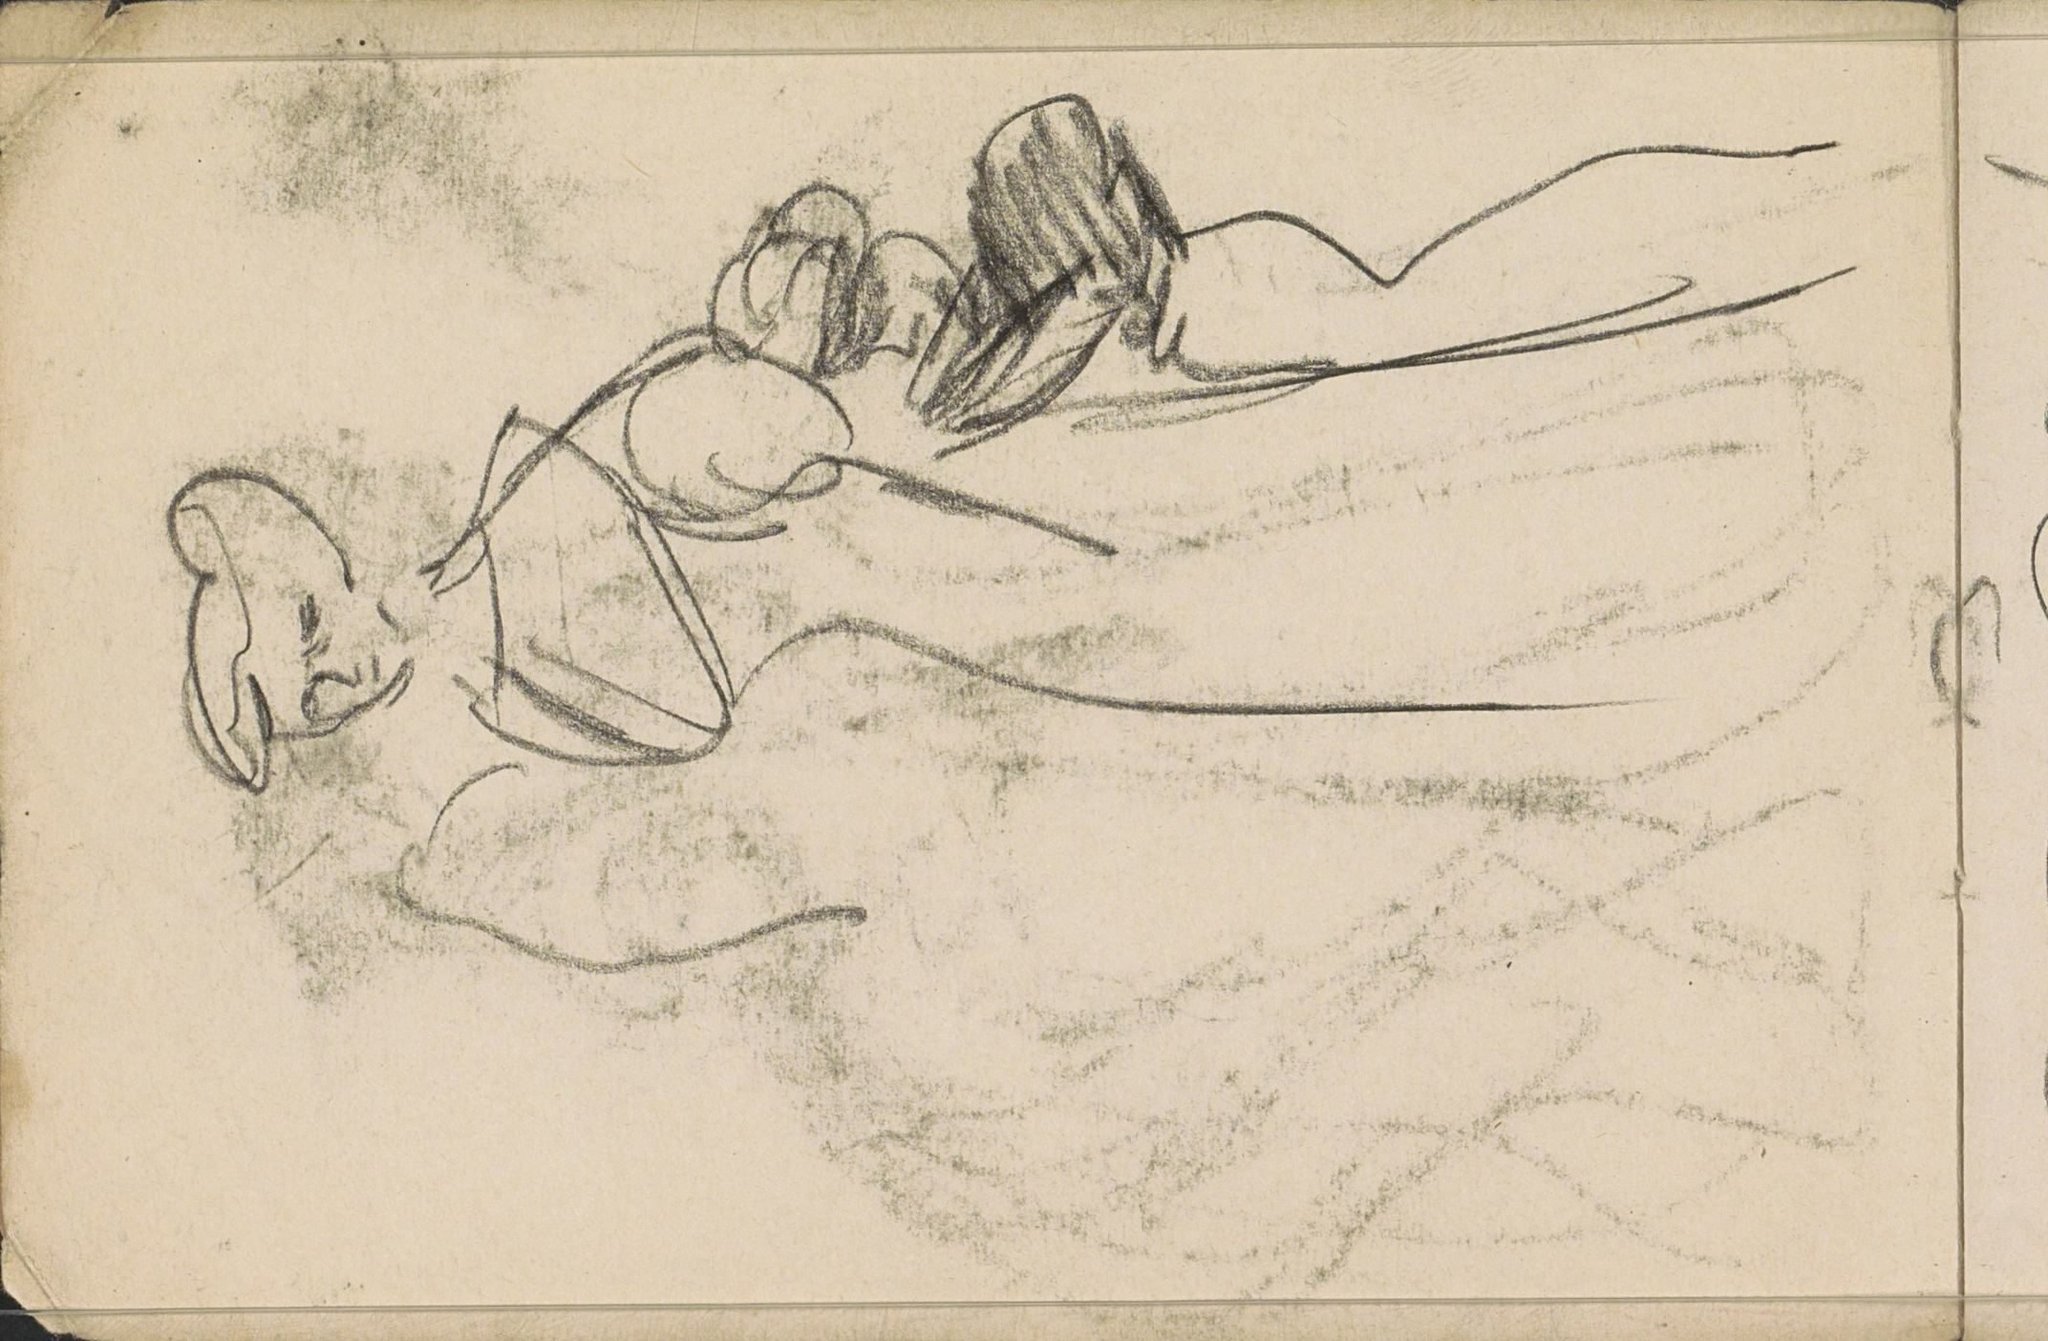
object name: sketchbook leaf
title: Staande vrouw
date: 1875-1934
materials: chalk, paper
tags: child, adult woman (+ standing)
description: Achter haar rug mogelijk kinderen. Pagina 2 uit schetsboek XLVI met 32 pagina's.